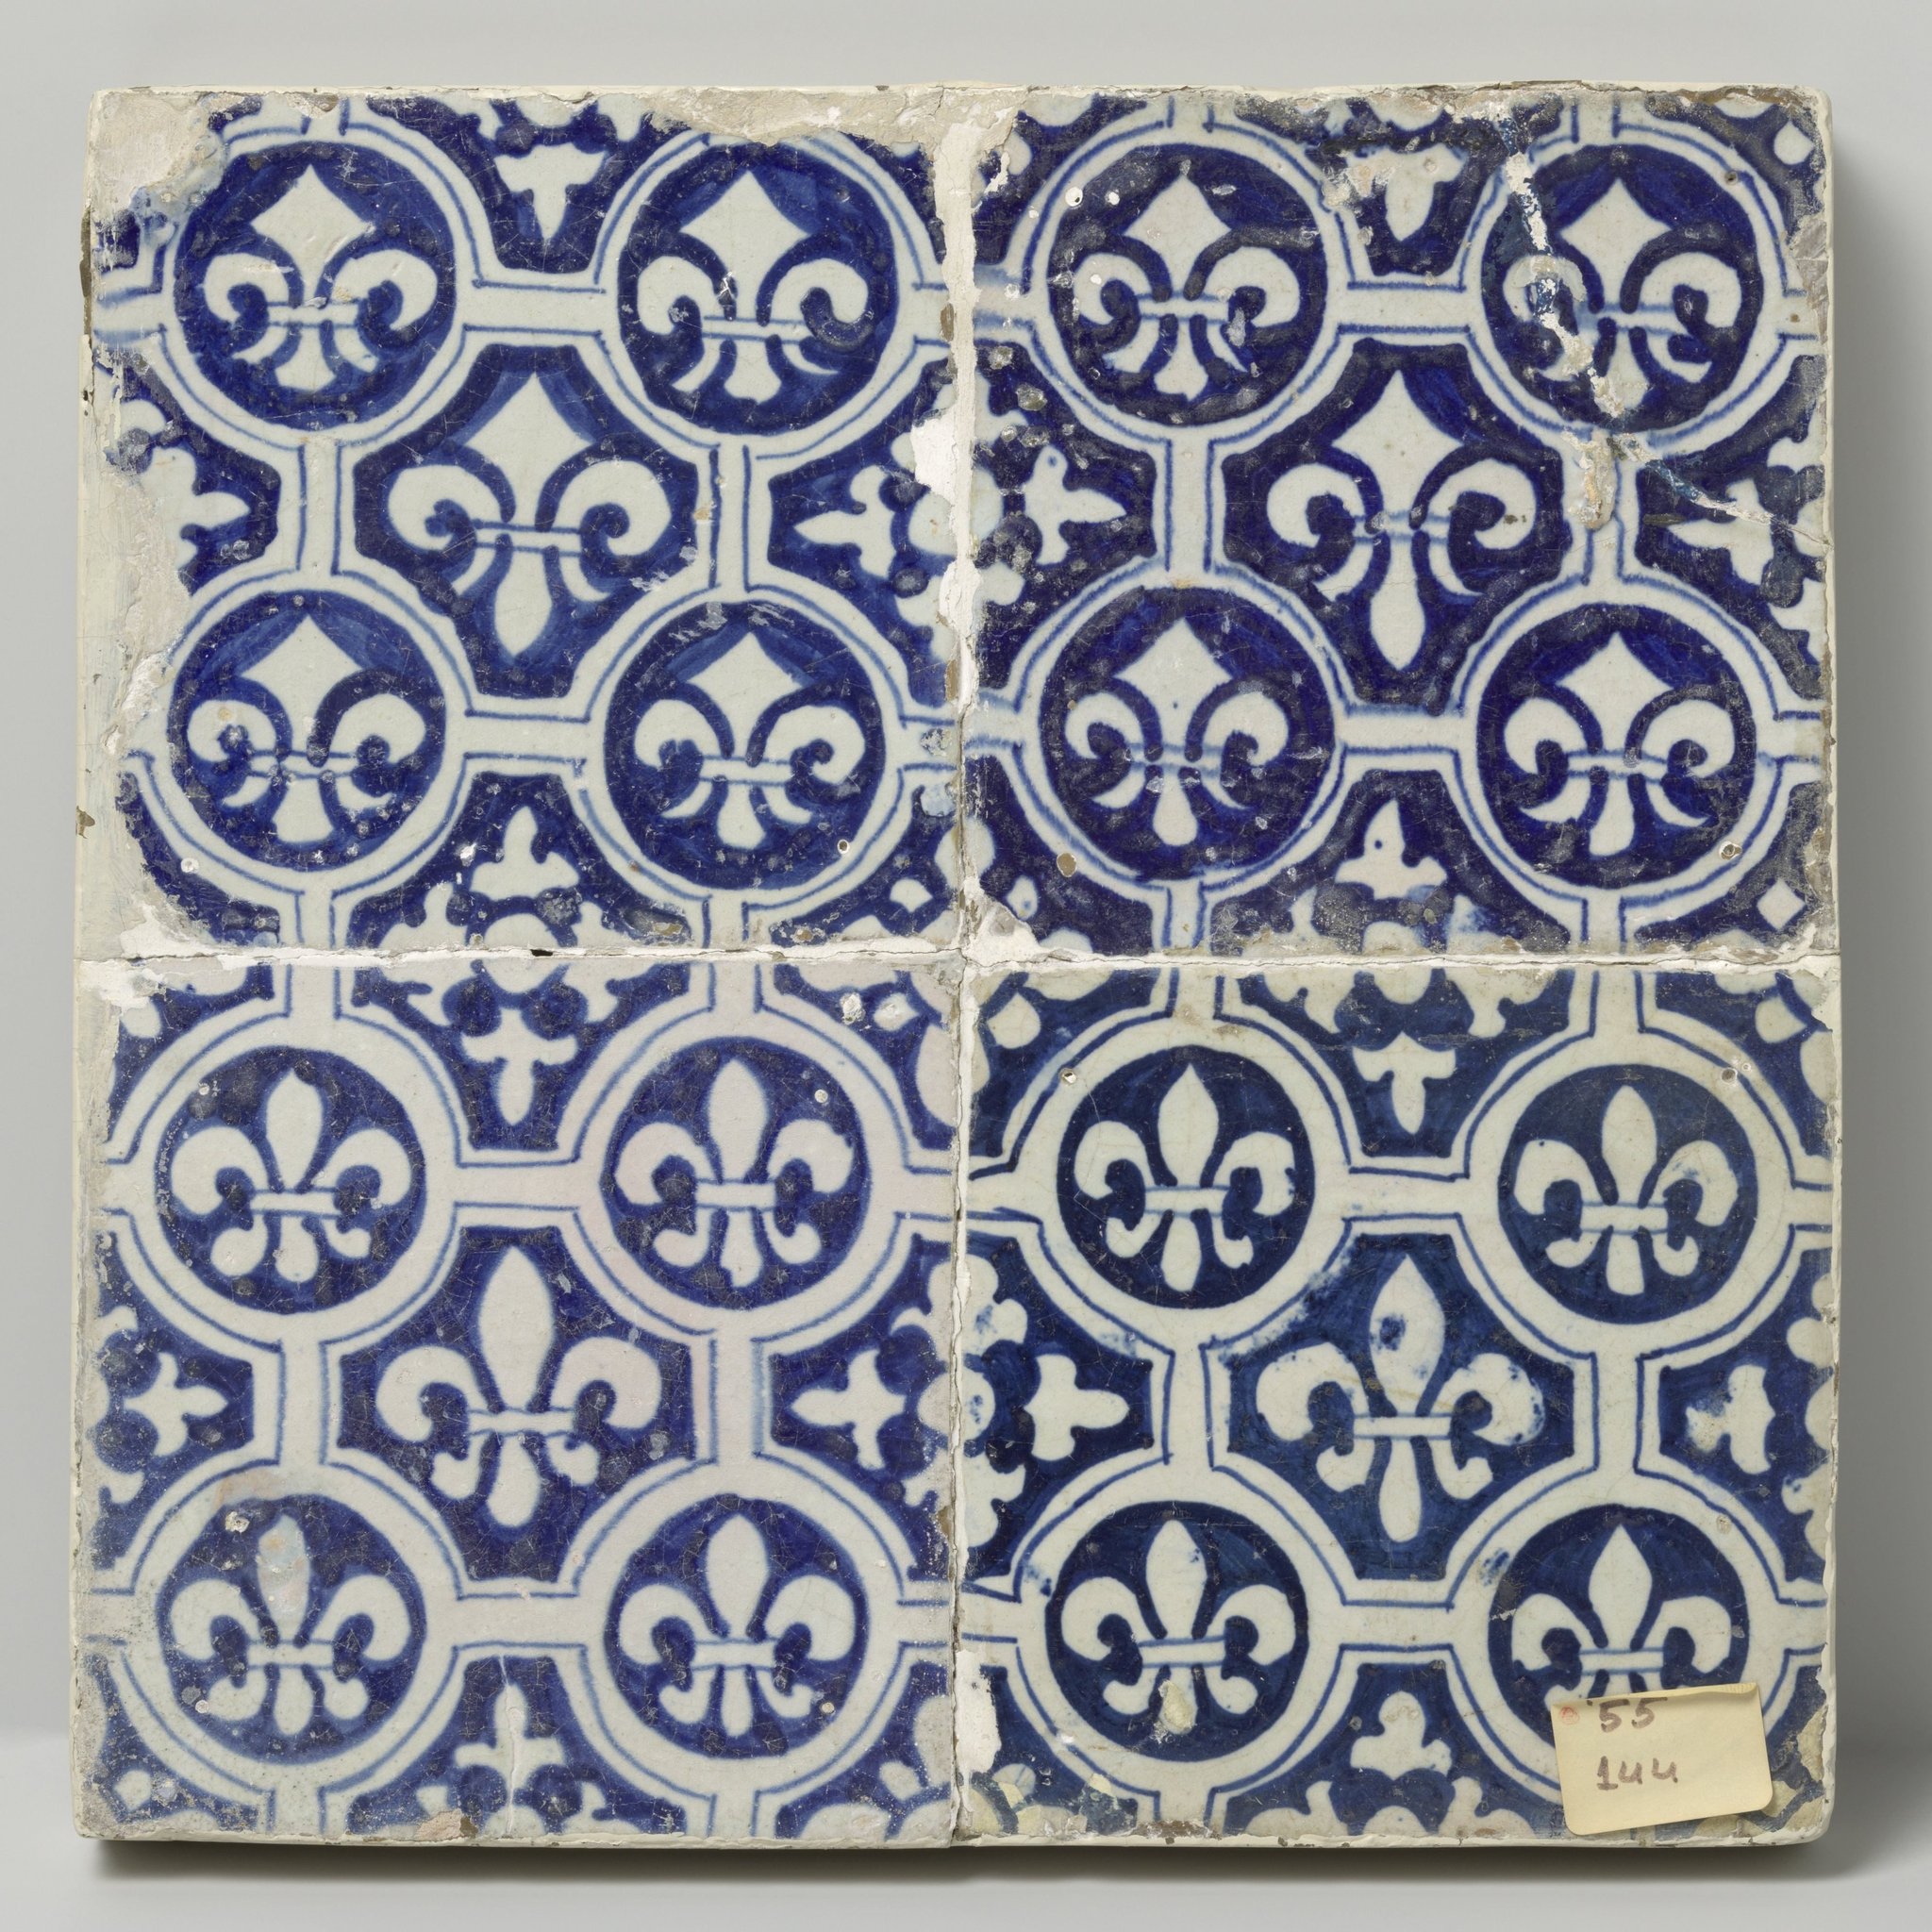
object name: tile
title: Veld van vier tegels met Franse lelies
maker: Anonymous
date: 1560-1600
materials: earthenware, glaze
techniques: maiolica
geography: netherlands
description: Veld van vier tegels (2 x 2) elk met blauw geschilderde Franse lelies in vultechniek.